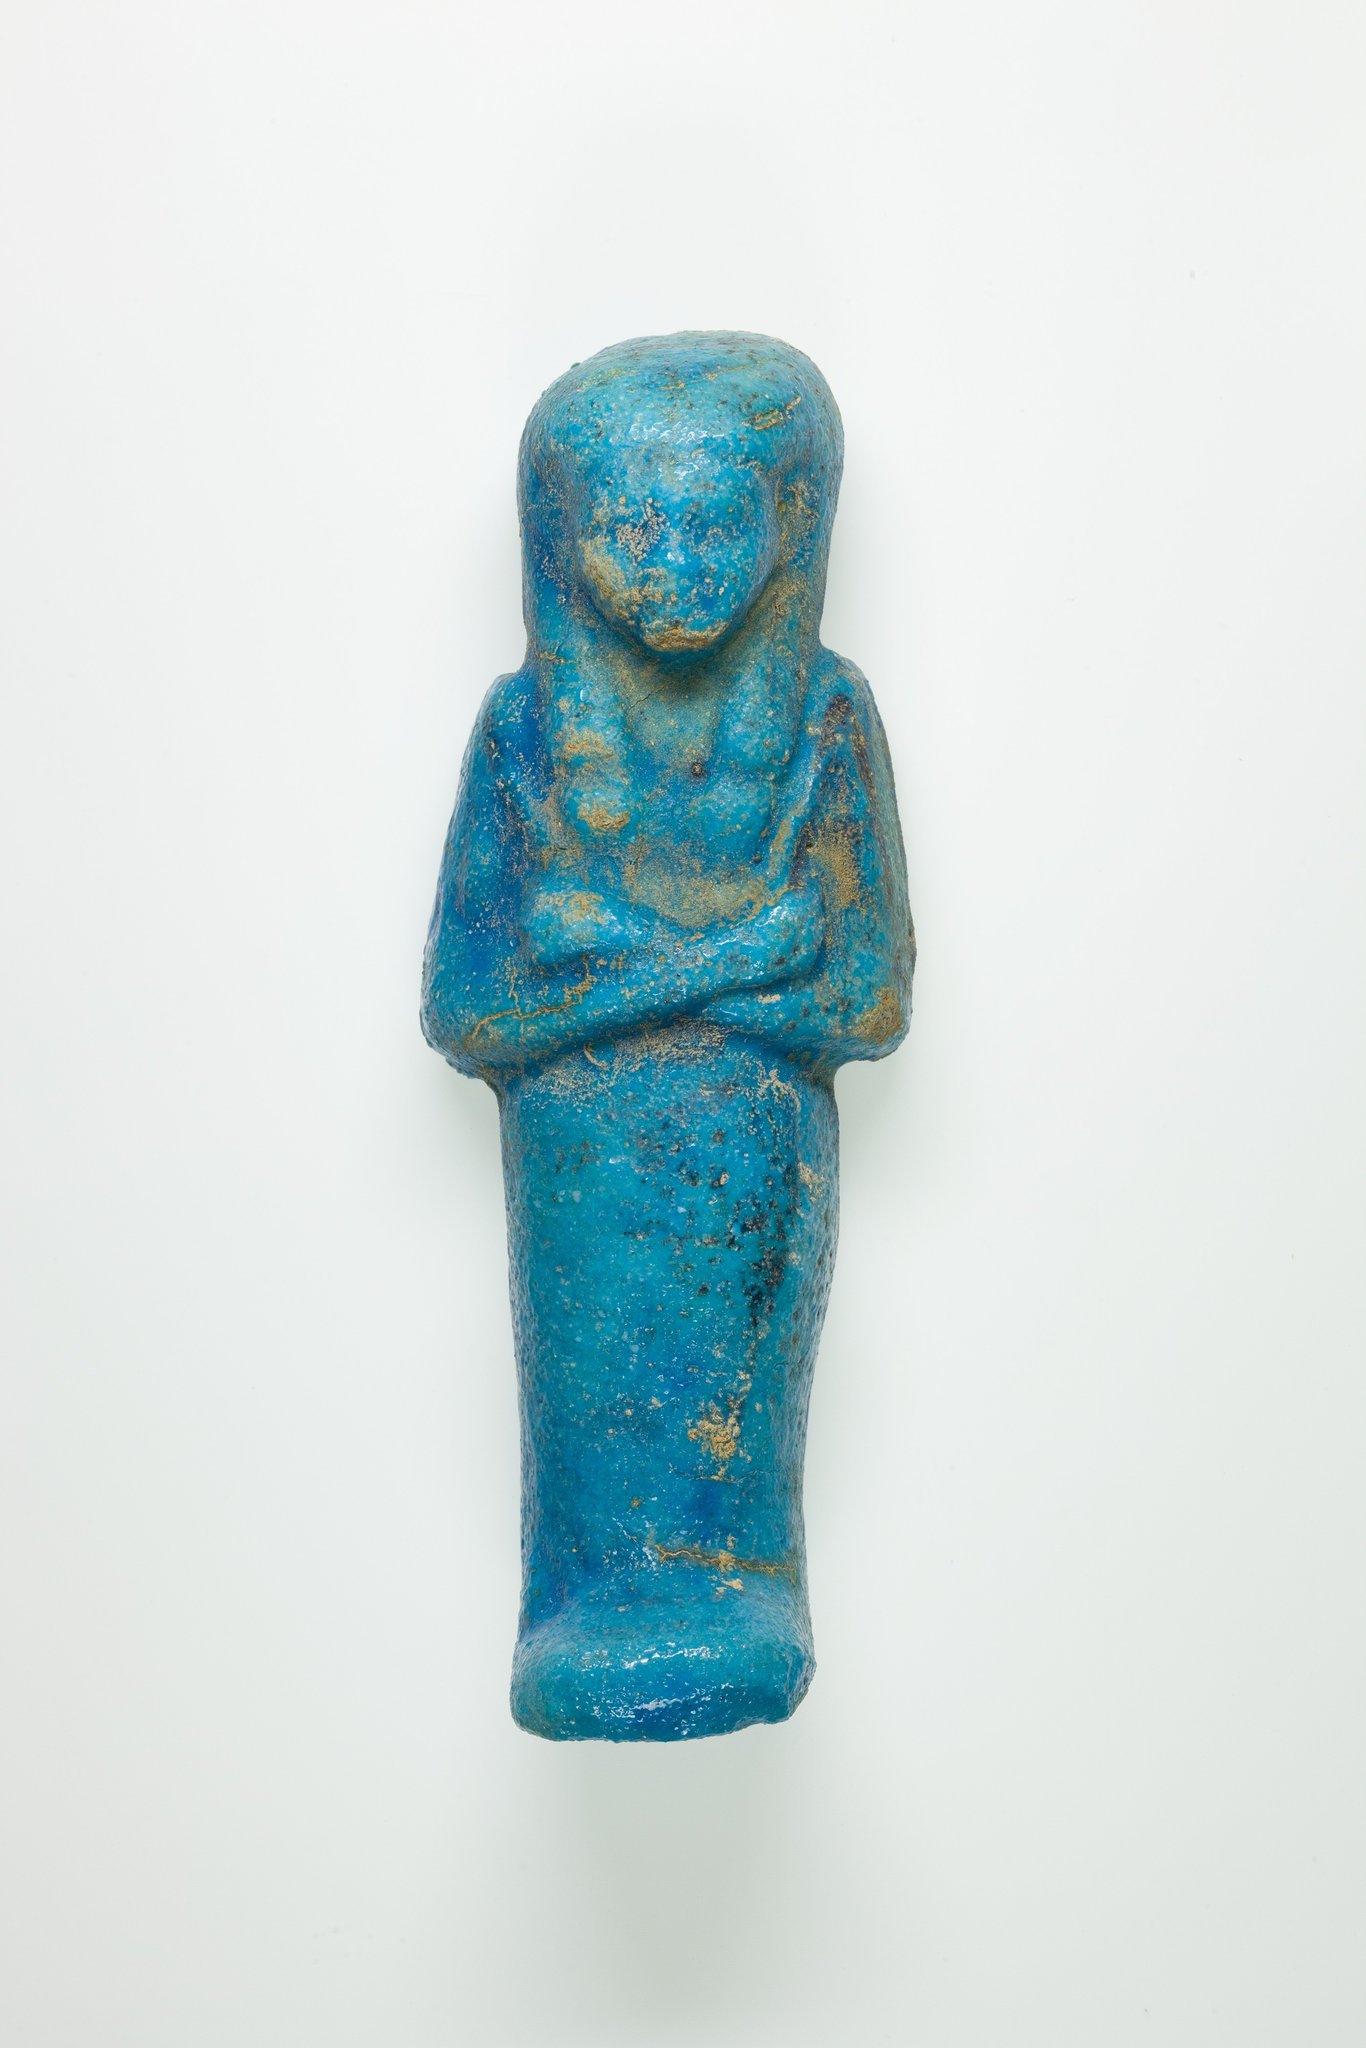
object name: worker shabti, henettawy c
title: Worker Shabti of Henettawy (C), Daughter of Isetemkheb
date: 990-970 BCE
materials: faience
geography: egypt